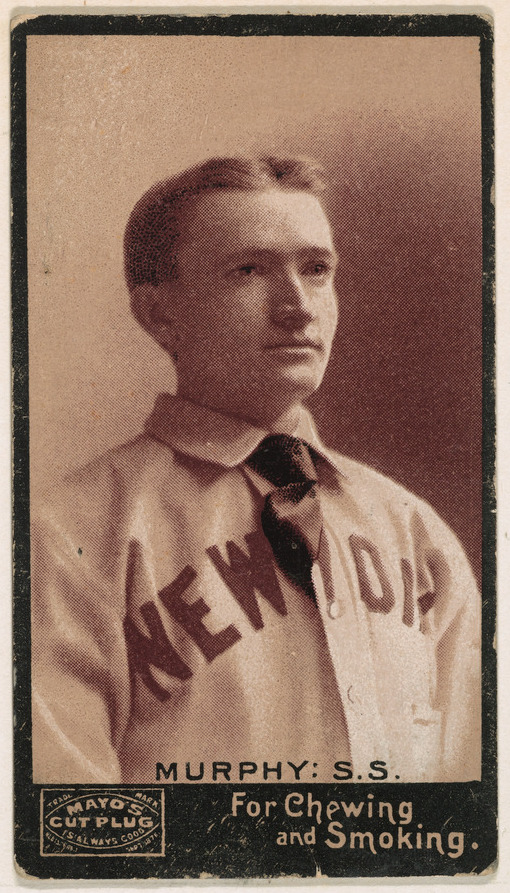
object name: print, baseball card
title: Murphy, Shortstop, New York, from Mayo's Cut Plug Baseball series (N300)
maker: p.h. mayo & brother, richmond, virginia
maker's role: publisher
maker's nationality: american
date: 1895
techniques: lithography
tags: men,portraits,baseball,athletes